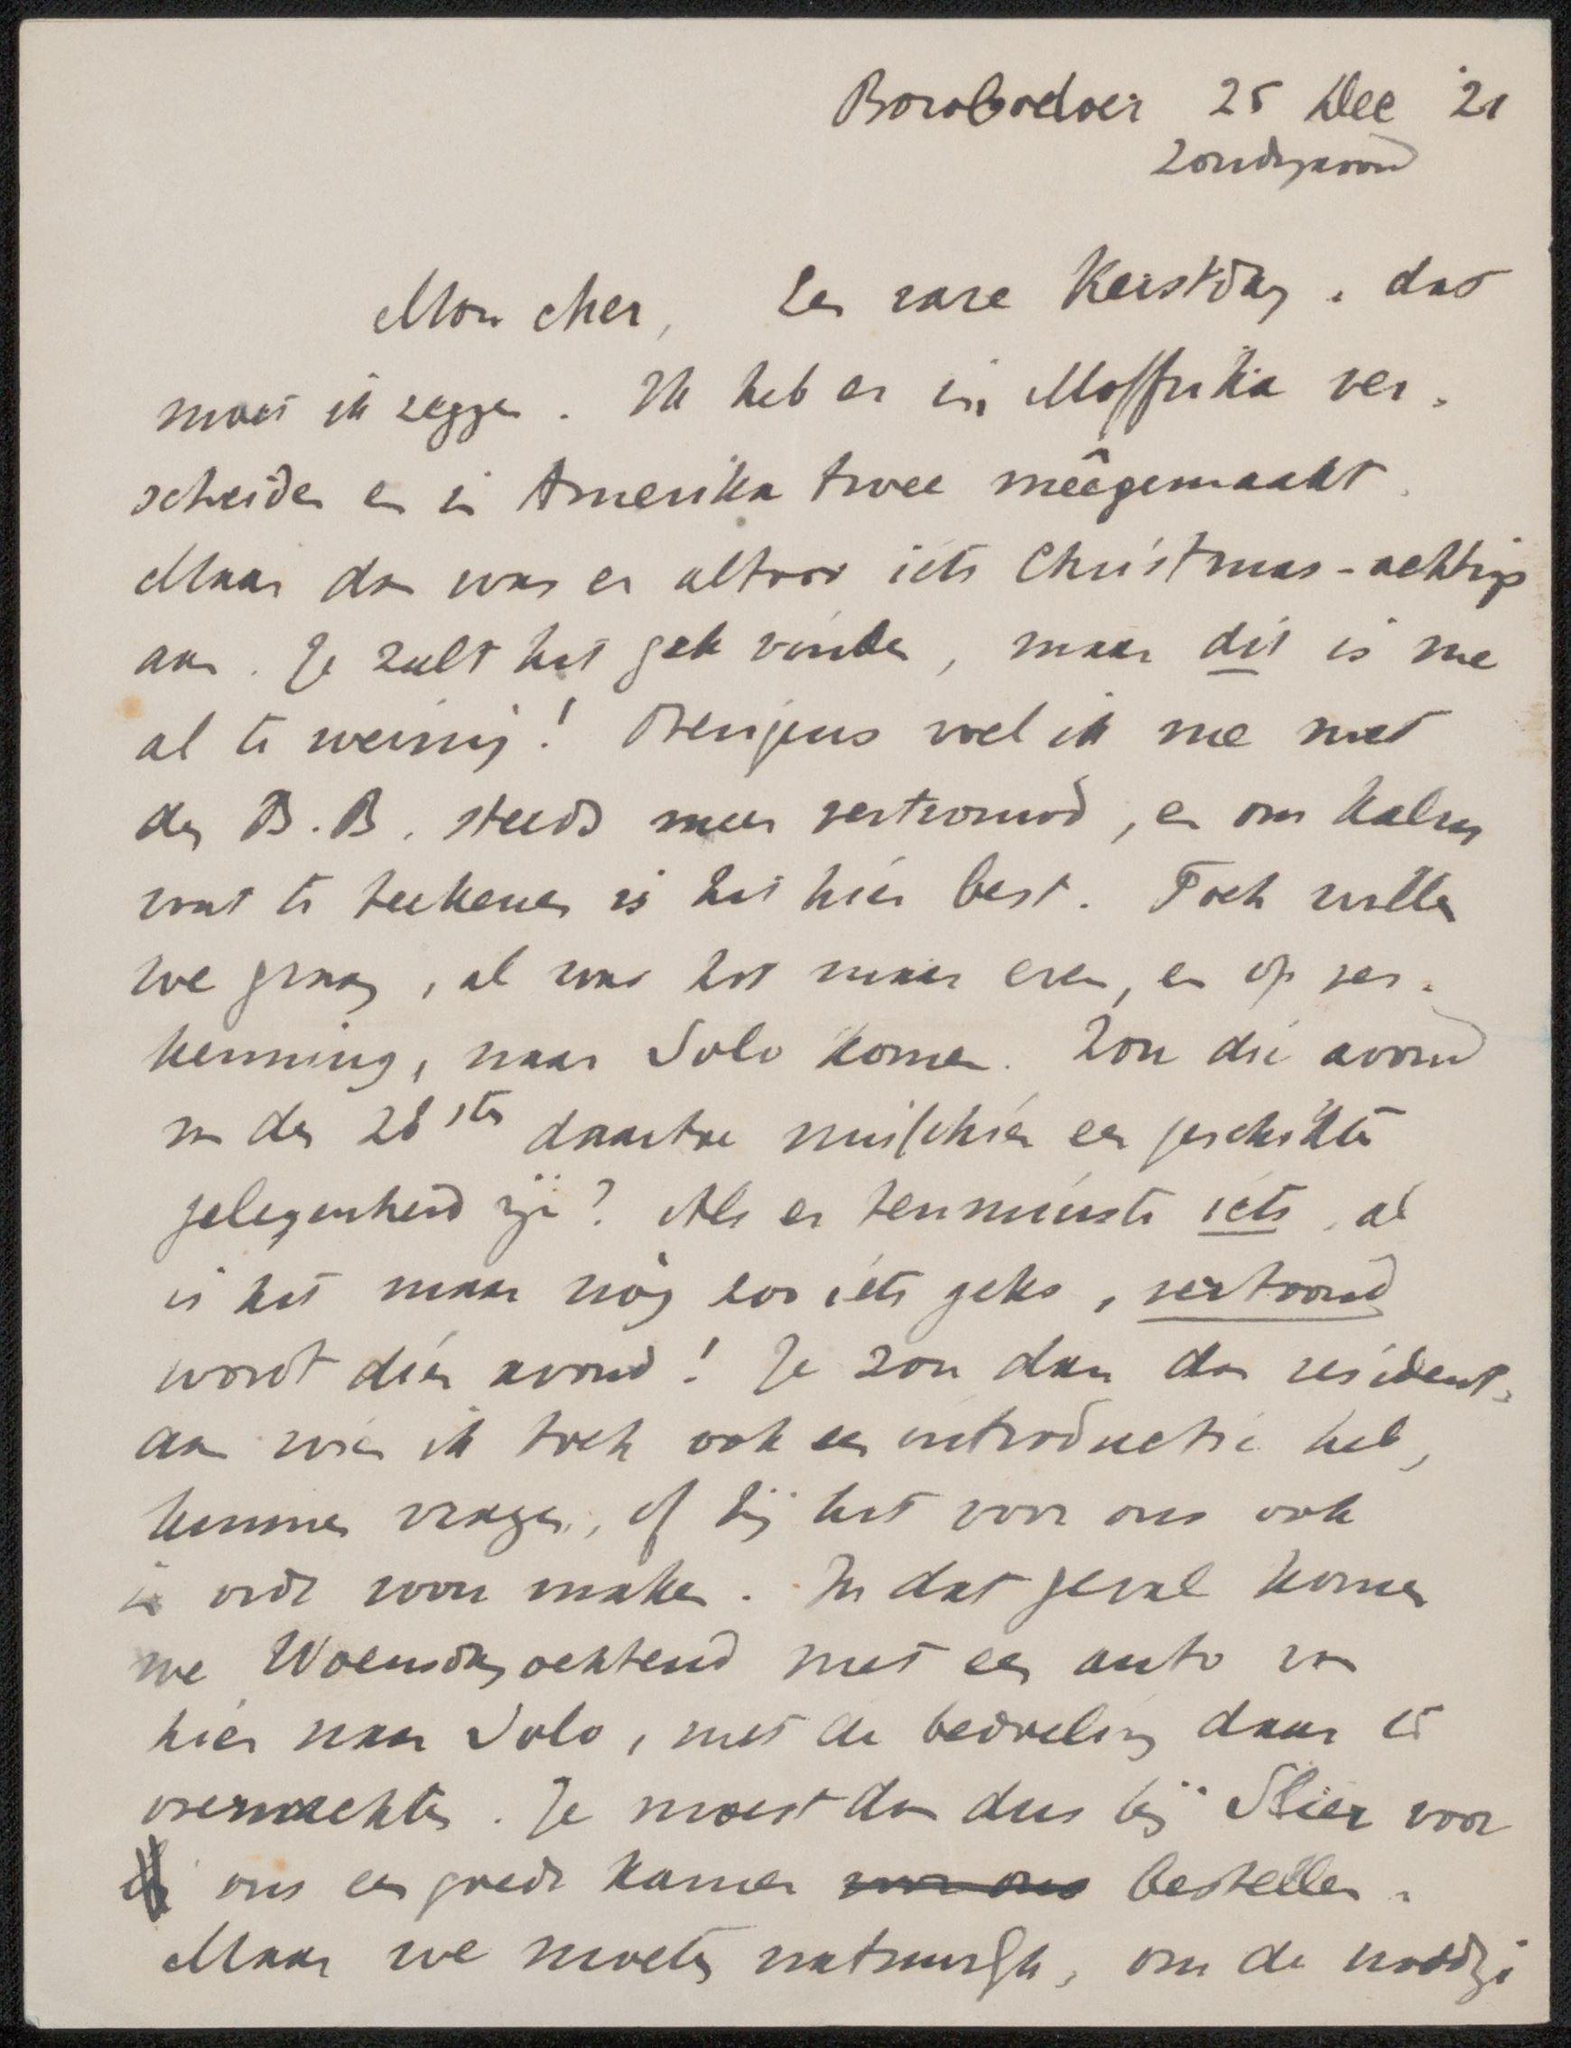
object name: letter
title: Brief aan Isaac Israels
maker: jan veth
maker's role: designer, draughtsman, painter, print maker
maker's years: 1864-1925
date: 1921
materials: ink, paper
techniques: pen, writing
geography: borobudur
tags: the hague, isaac israels, drawing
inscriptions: collector's mark: ‘RPK’